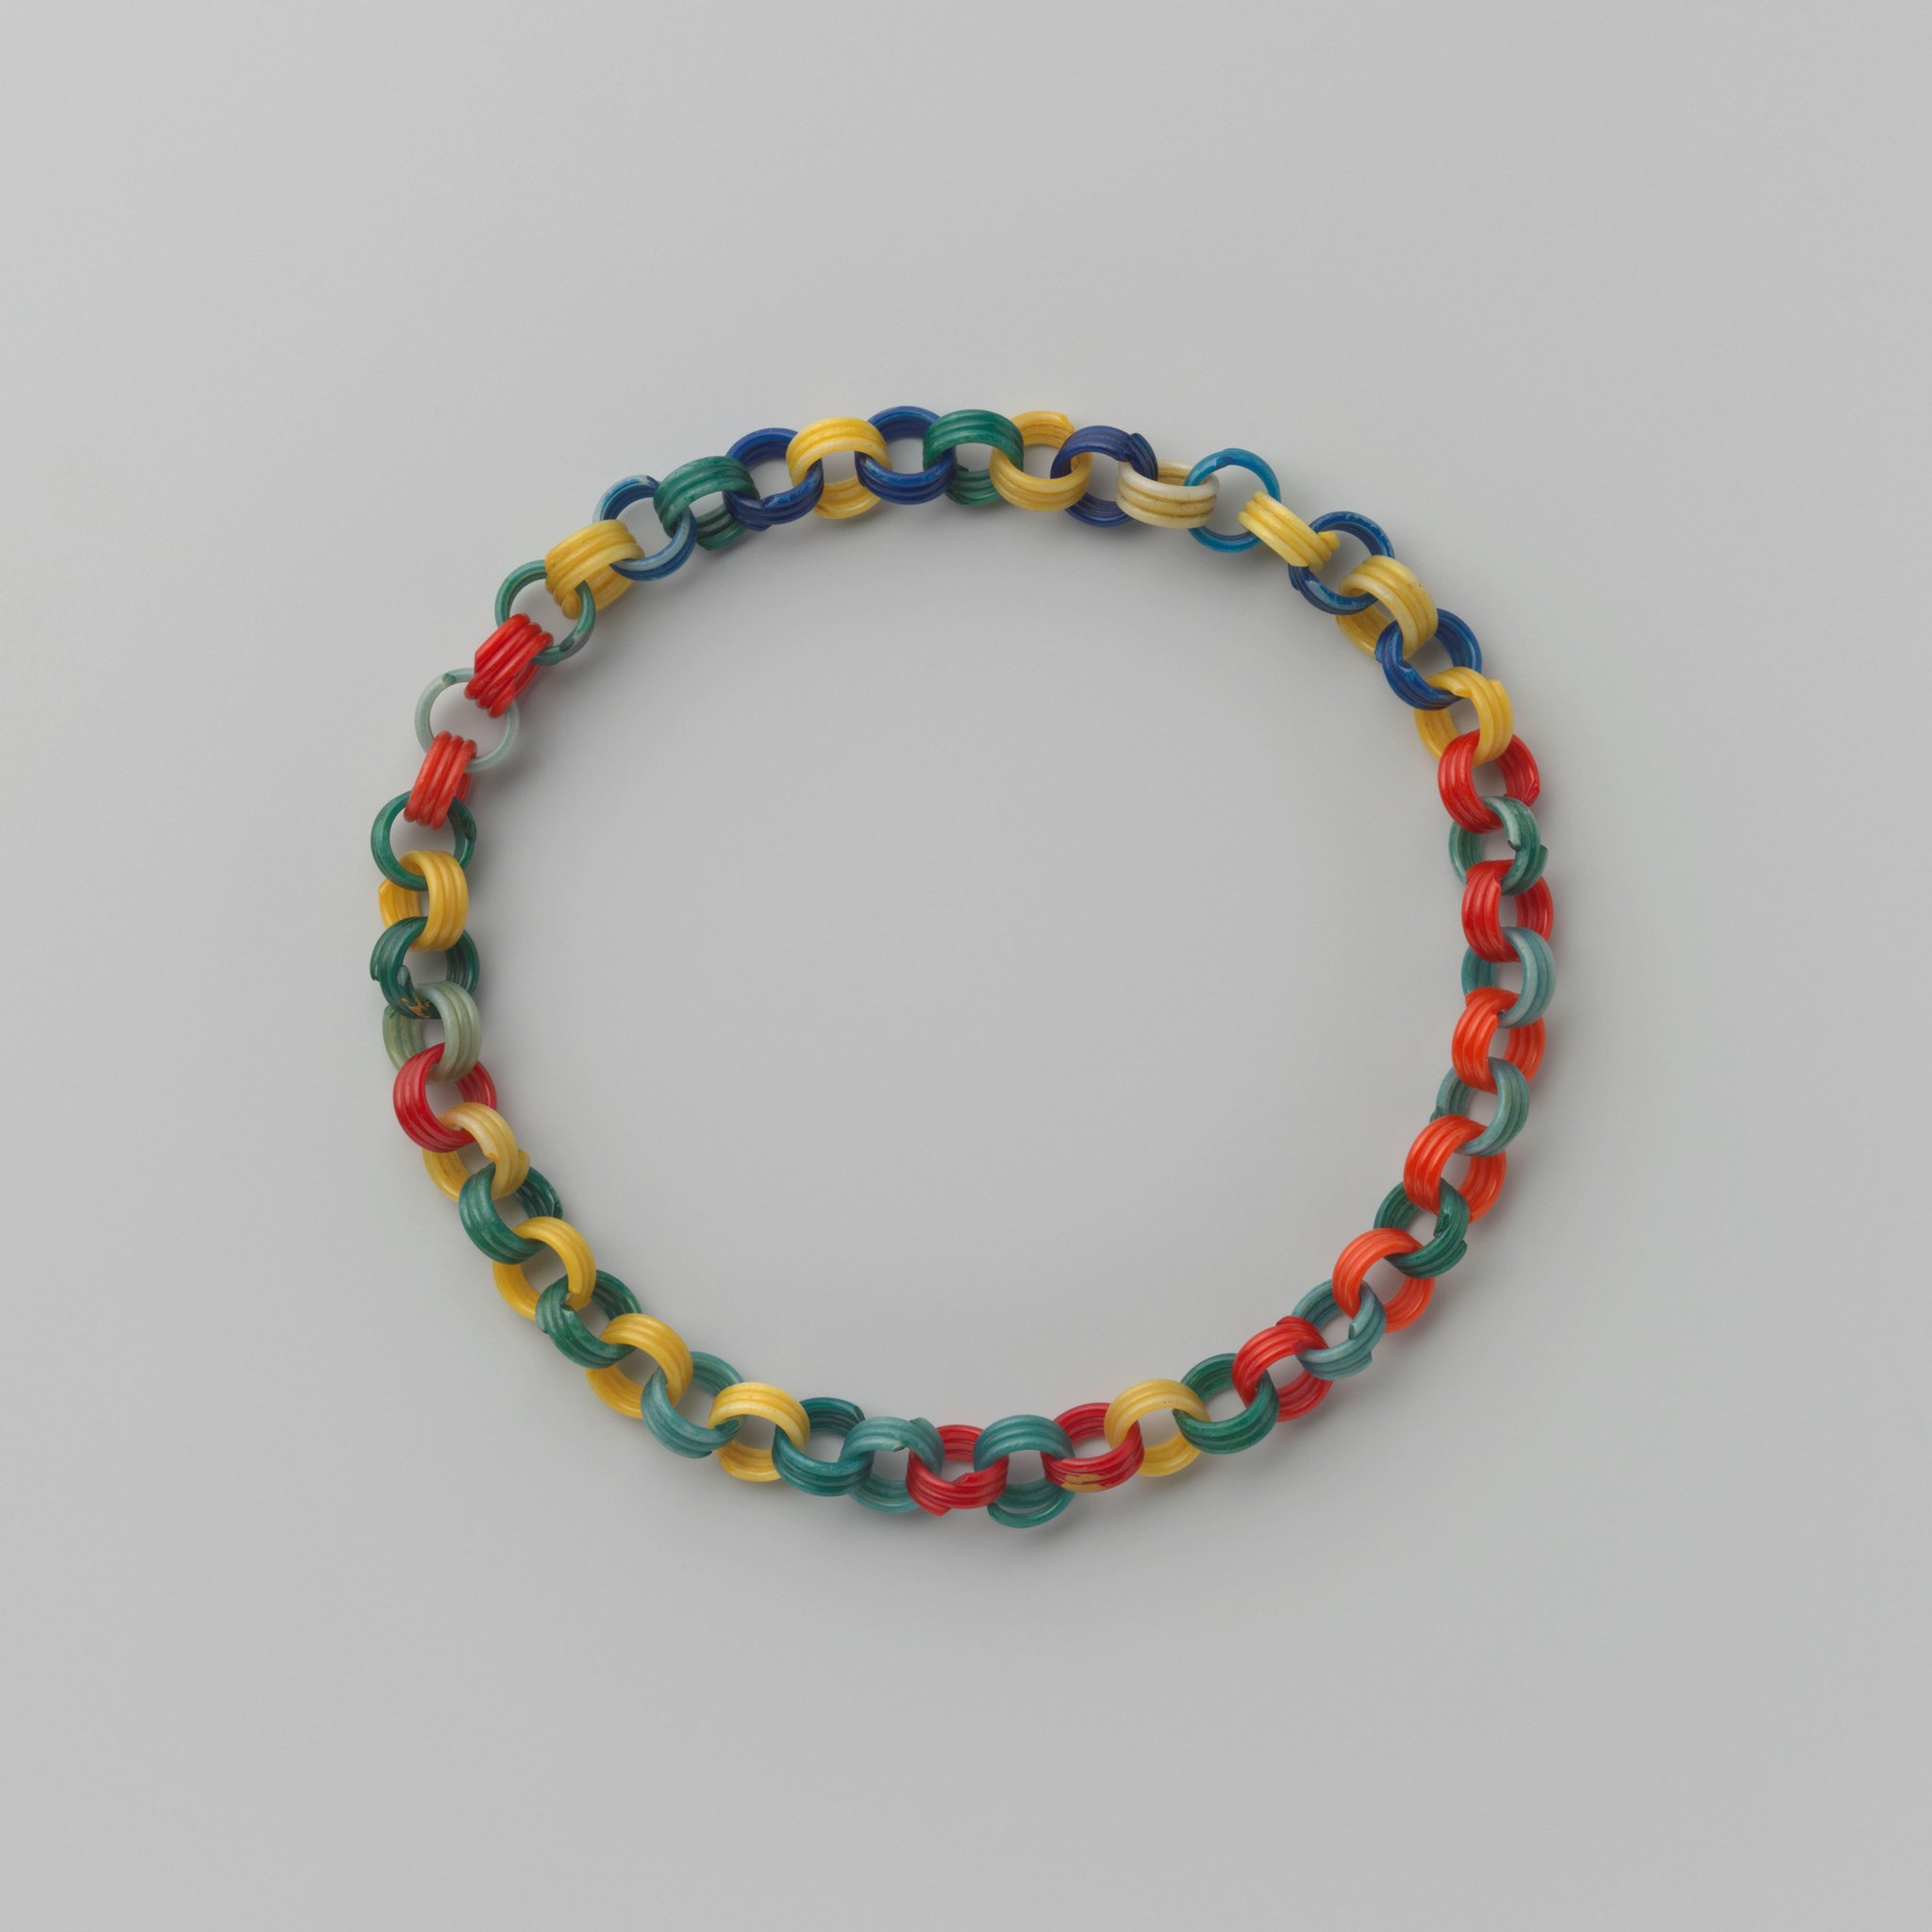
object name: necklace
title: Collier van kippenringen in verschillende kleuren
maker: Anonymous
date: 1950-1990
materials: plastic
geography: netherlands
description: Collier van vijftig kippenringen in de kleuren geel, groen, blauw en rood.